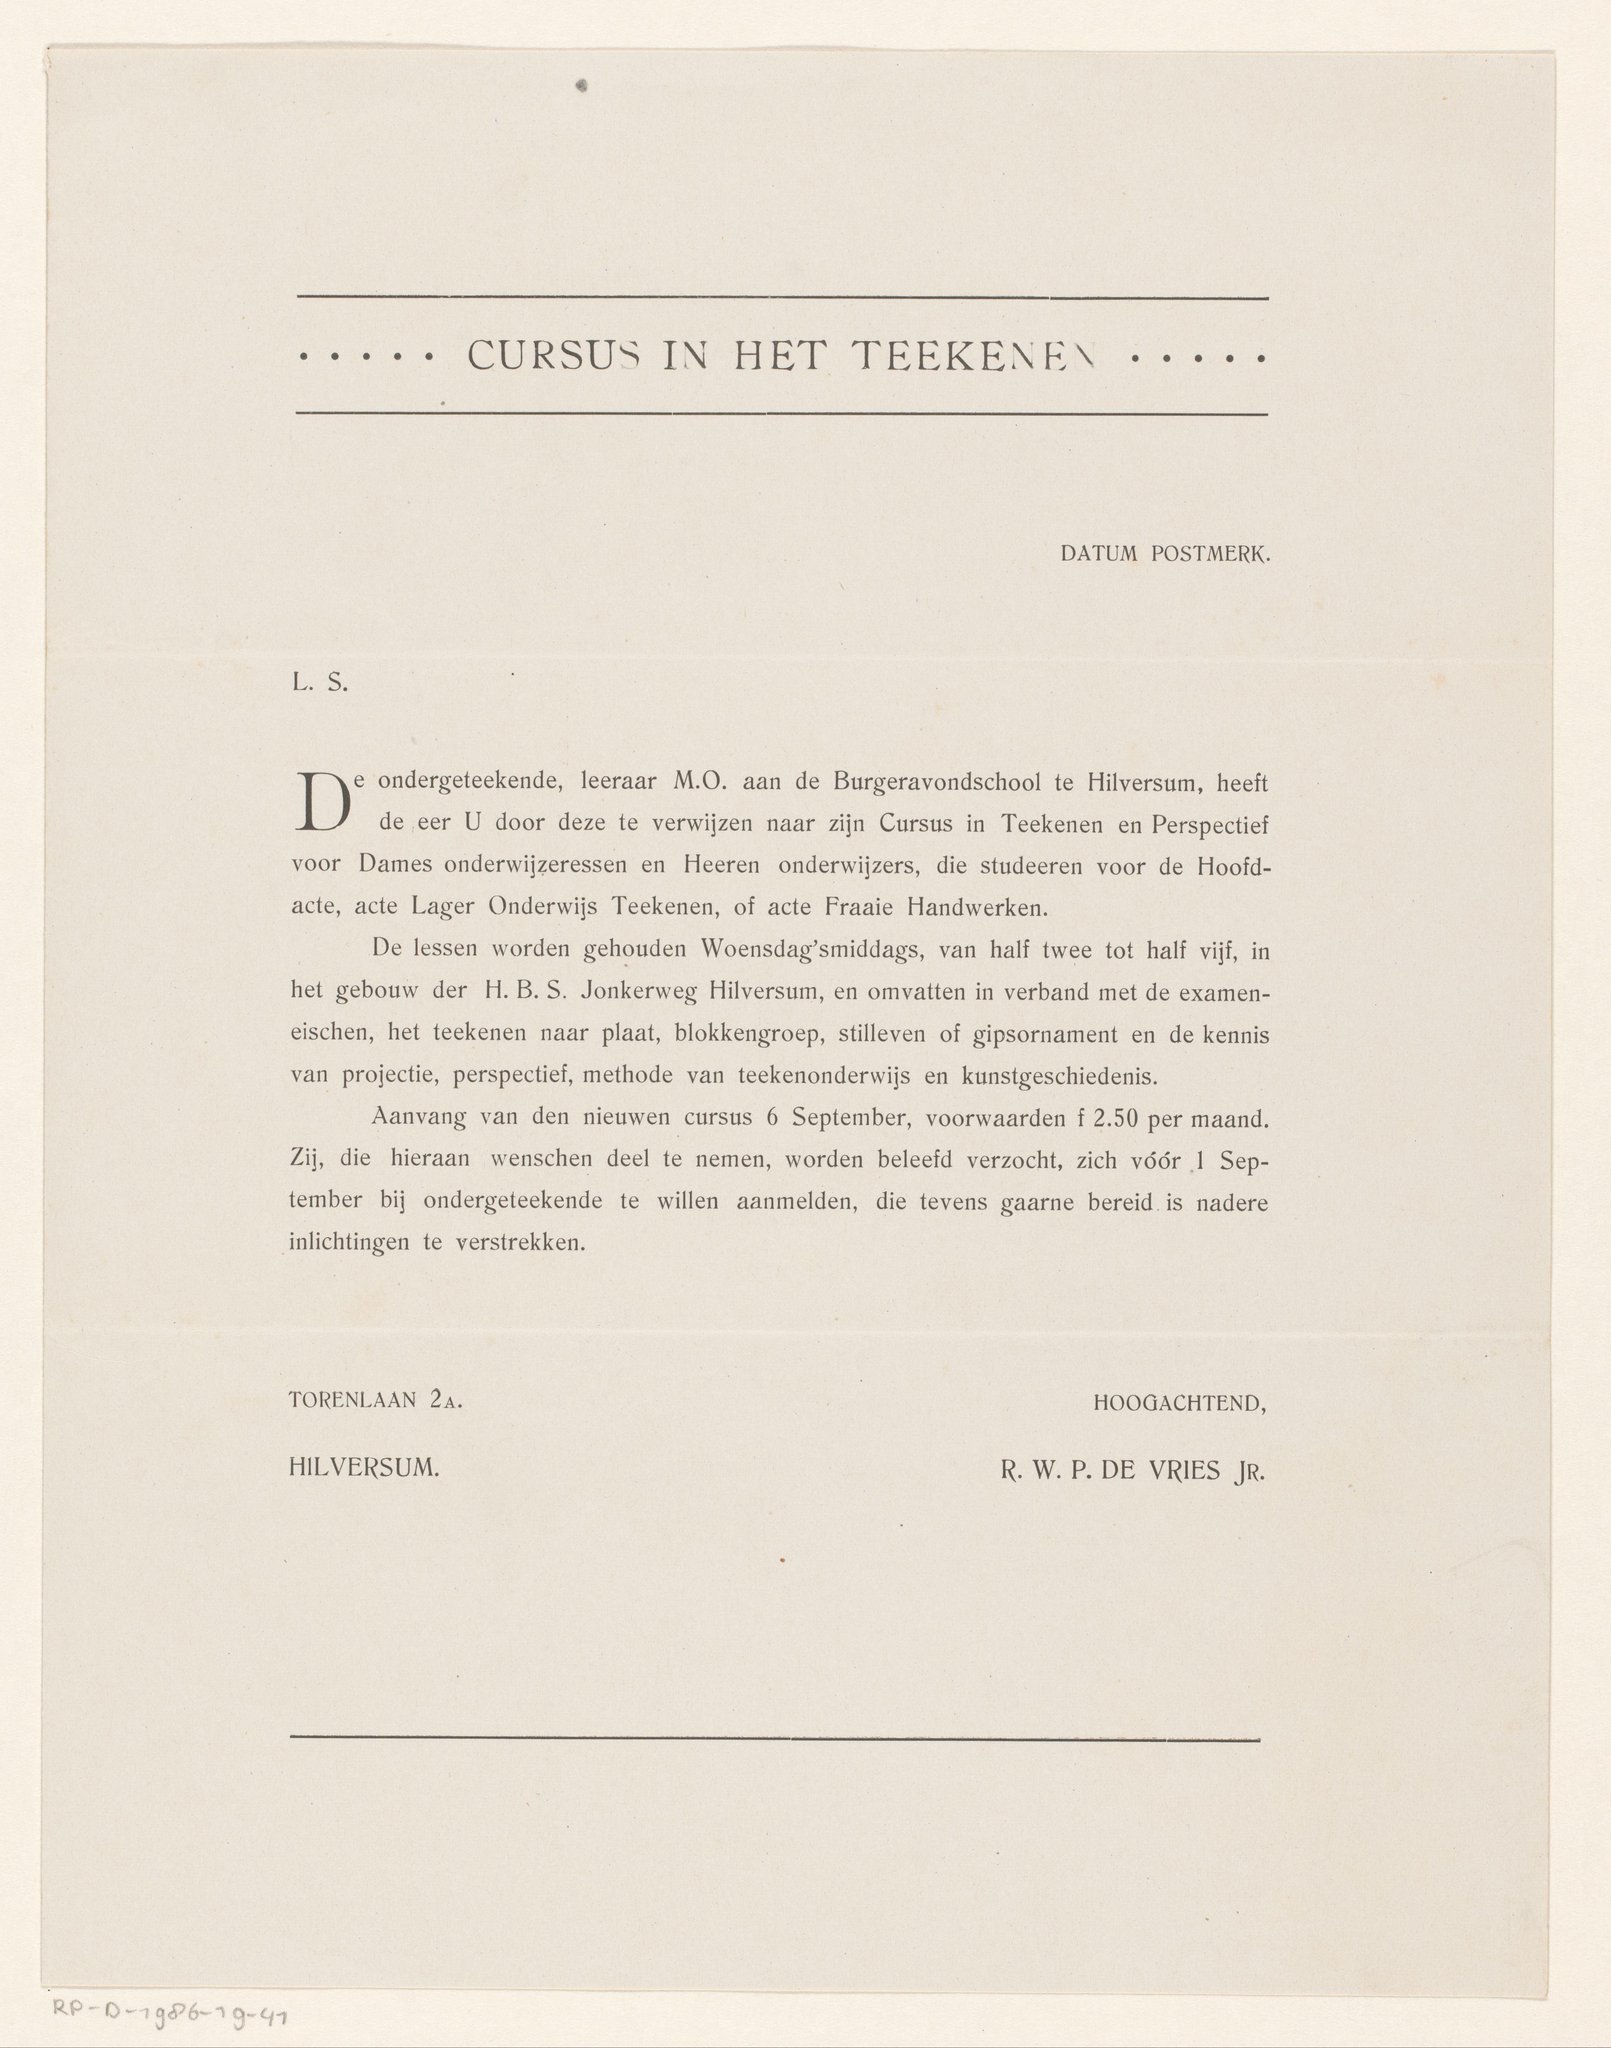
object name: letter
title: Brief aan anoniem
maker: reinier willem petrus de vries (1874-1953)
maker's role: draughtsman, print maker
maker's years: 1874-1953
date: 1884-1952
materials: paper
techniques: typewriting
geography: hilversum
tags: education, tuition of the artist (in general)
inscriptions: collector's mark: ‘R:MVS.’